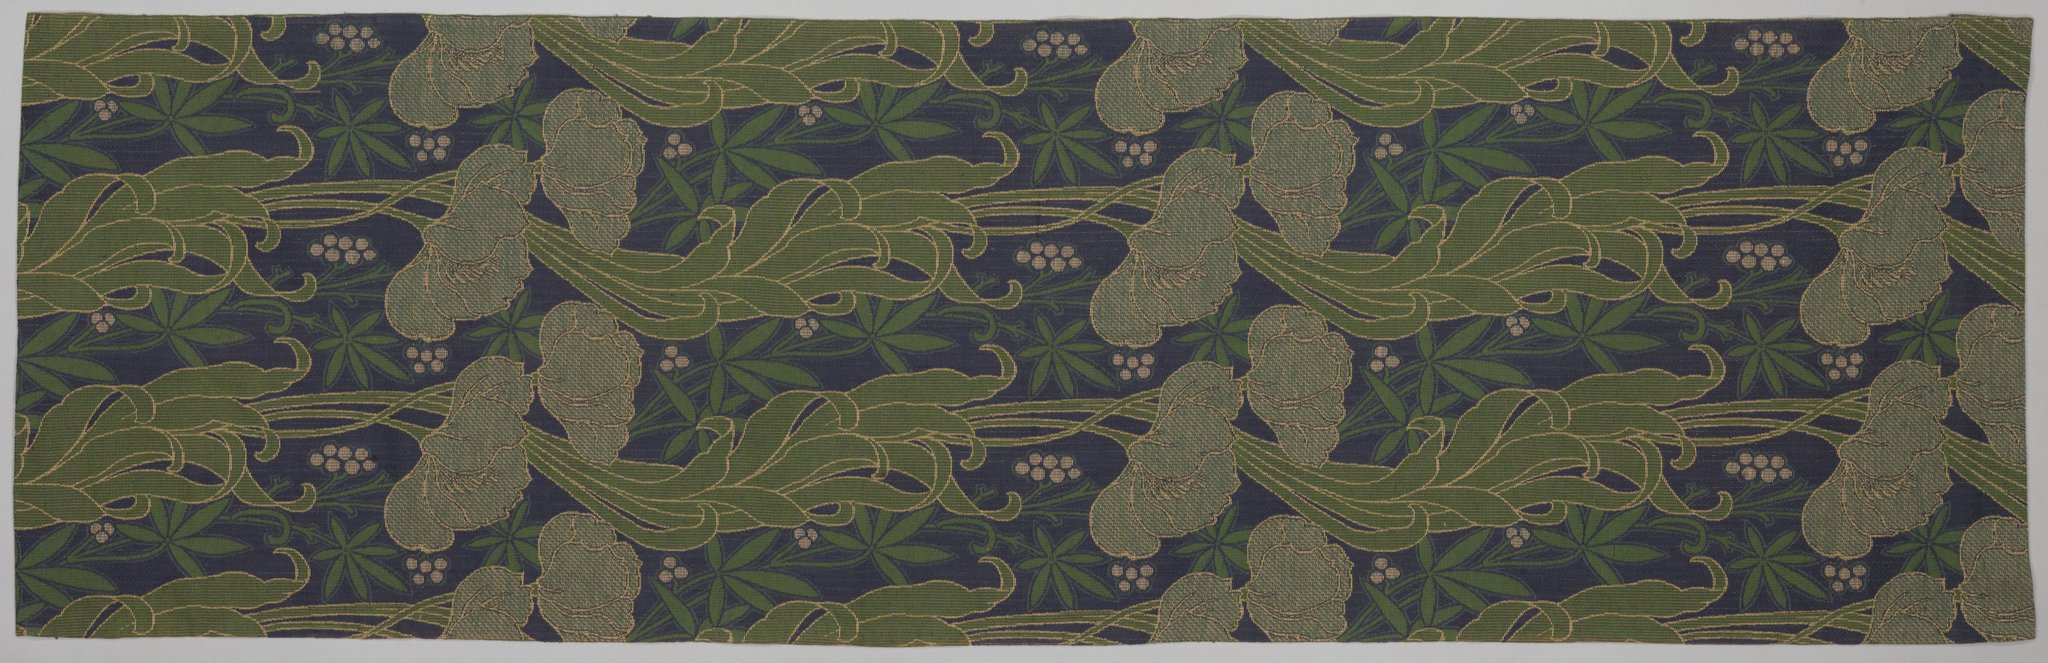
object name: upholstered wall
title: Baan bespanningsstof met Jugendstilpatroon van grote bloemen en bladeren die licht golvende banen vormen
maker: Anonymous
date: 1900-1920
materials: cotton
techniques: weave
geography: england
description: Baan bespanningsstof met Jugendstilpatroon van grote bloemen en bladeren die licht golvende banen vormen.